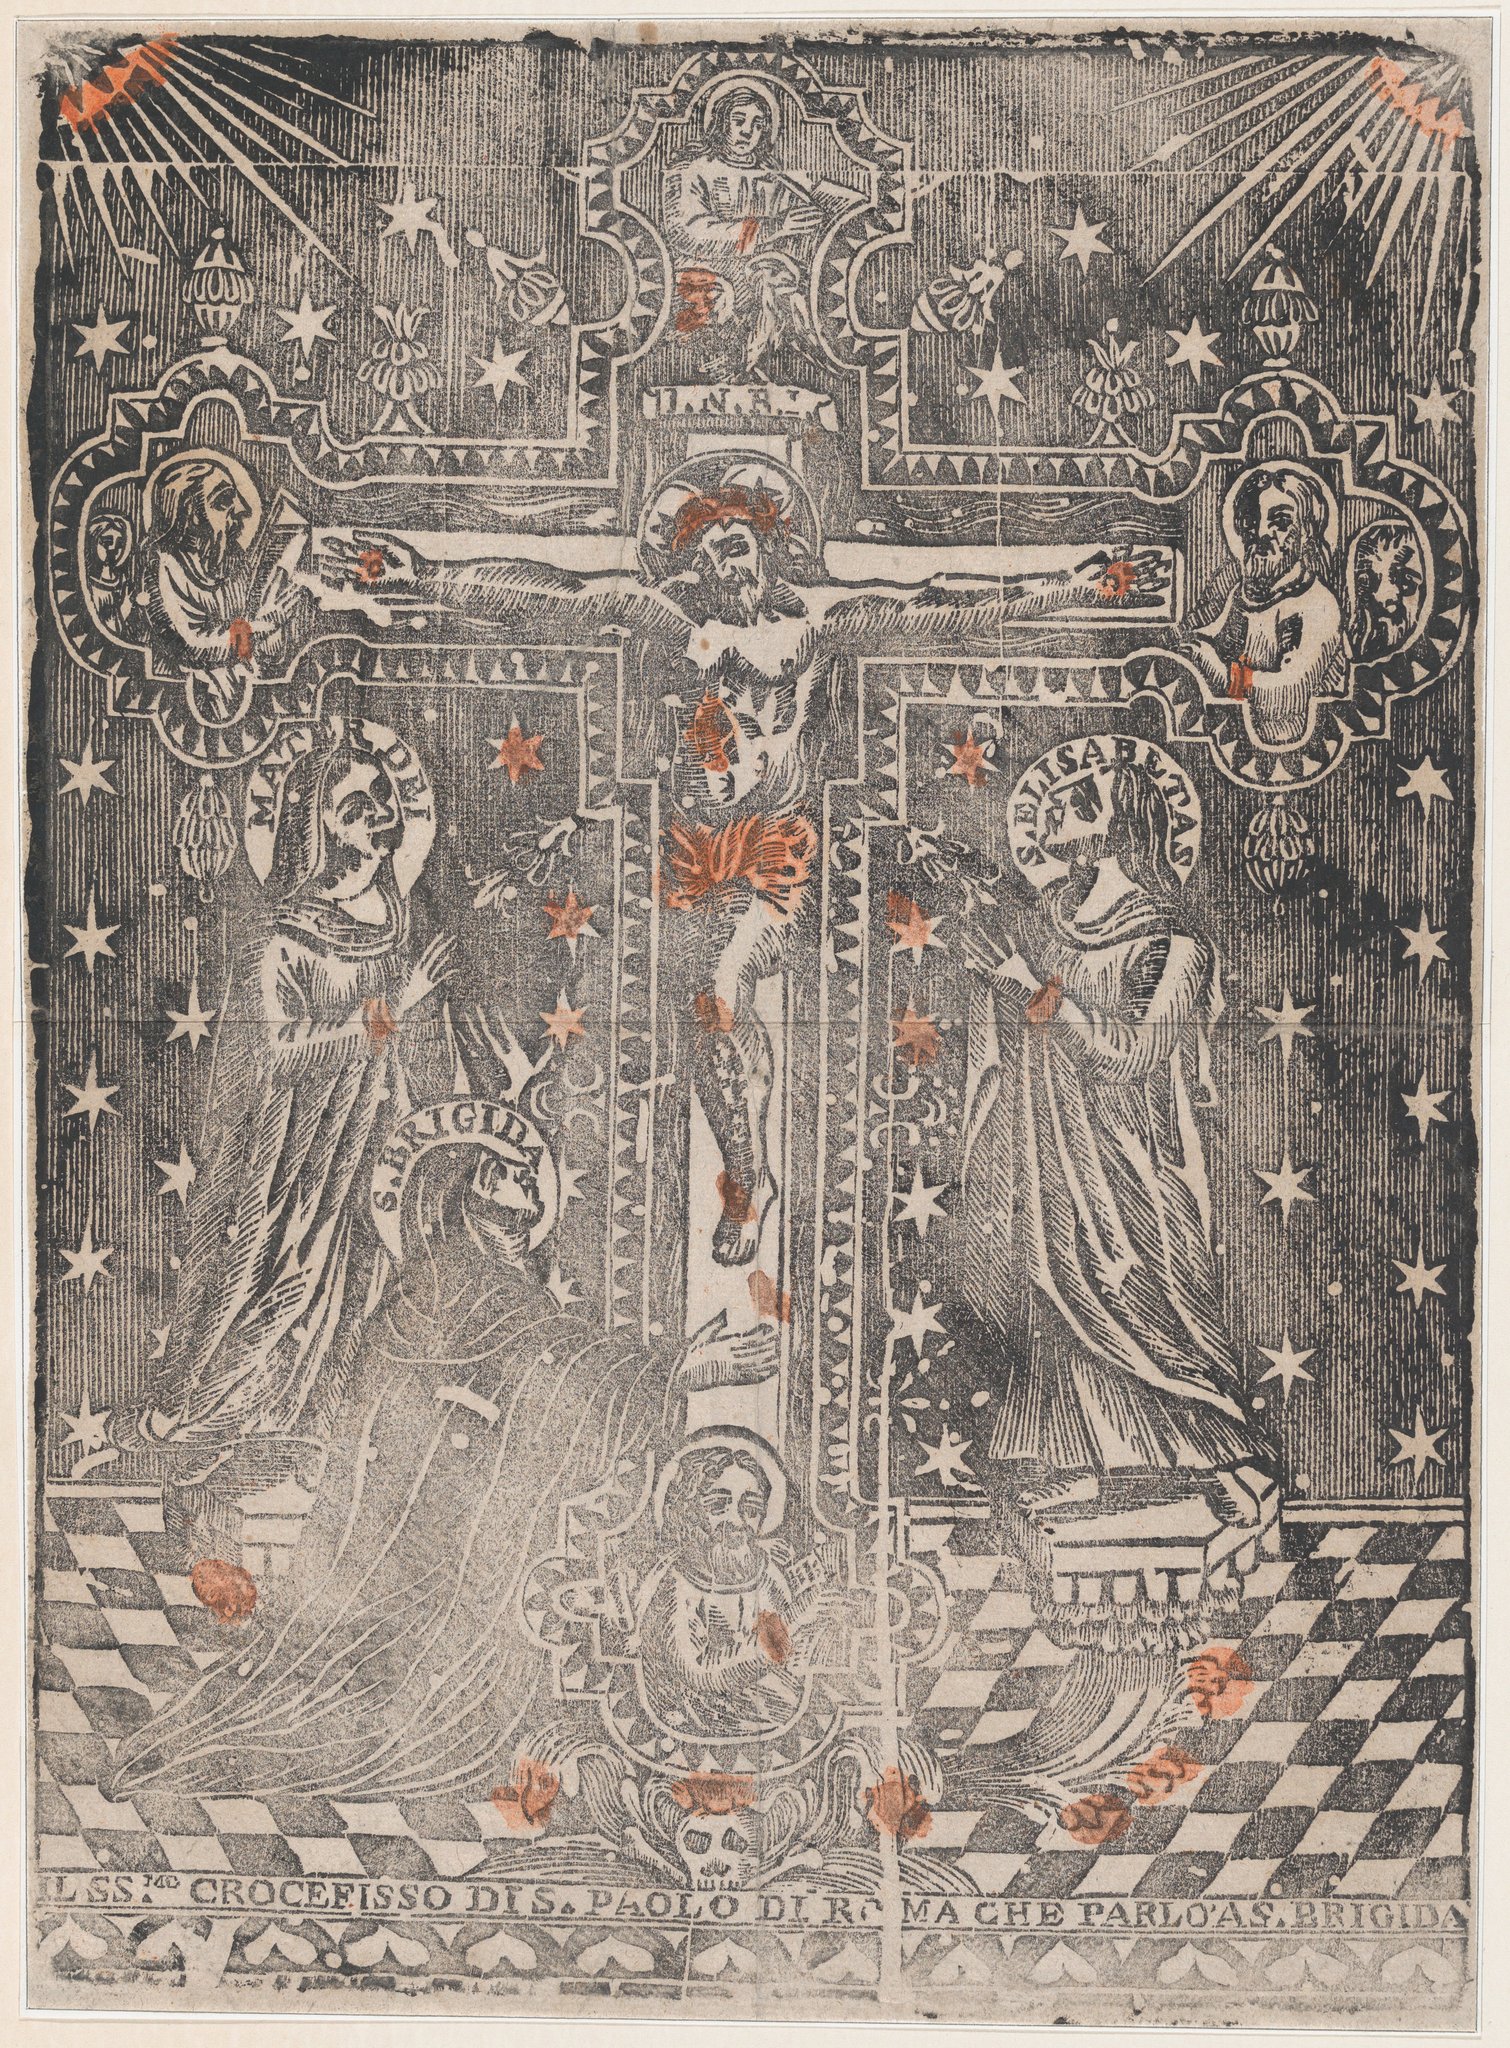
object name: print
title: Christ on the cross flanked by the Virgin, Saint Brigit and Saint Elisabeth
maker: anonymous, italian, 16th century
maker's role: artist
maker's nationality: italian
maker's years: 1500-1600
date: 1480-1500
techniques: woodcut